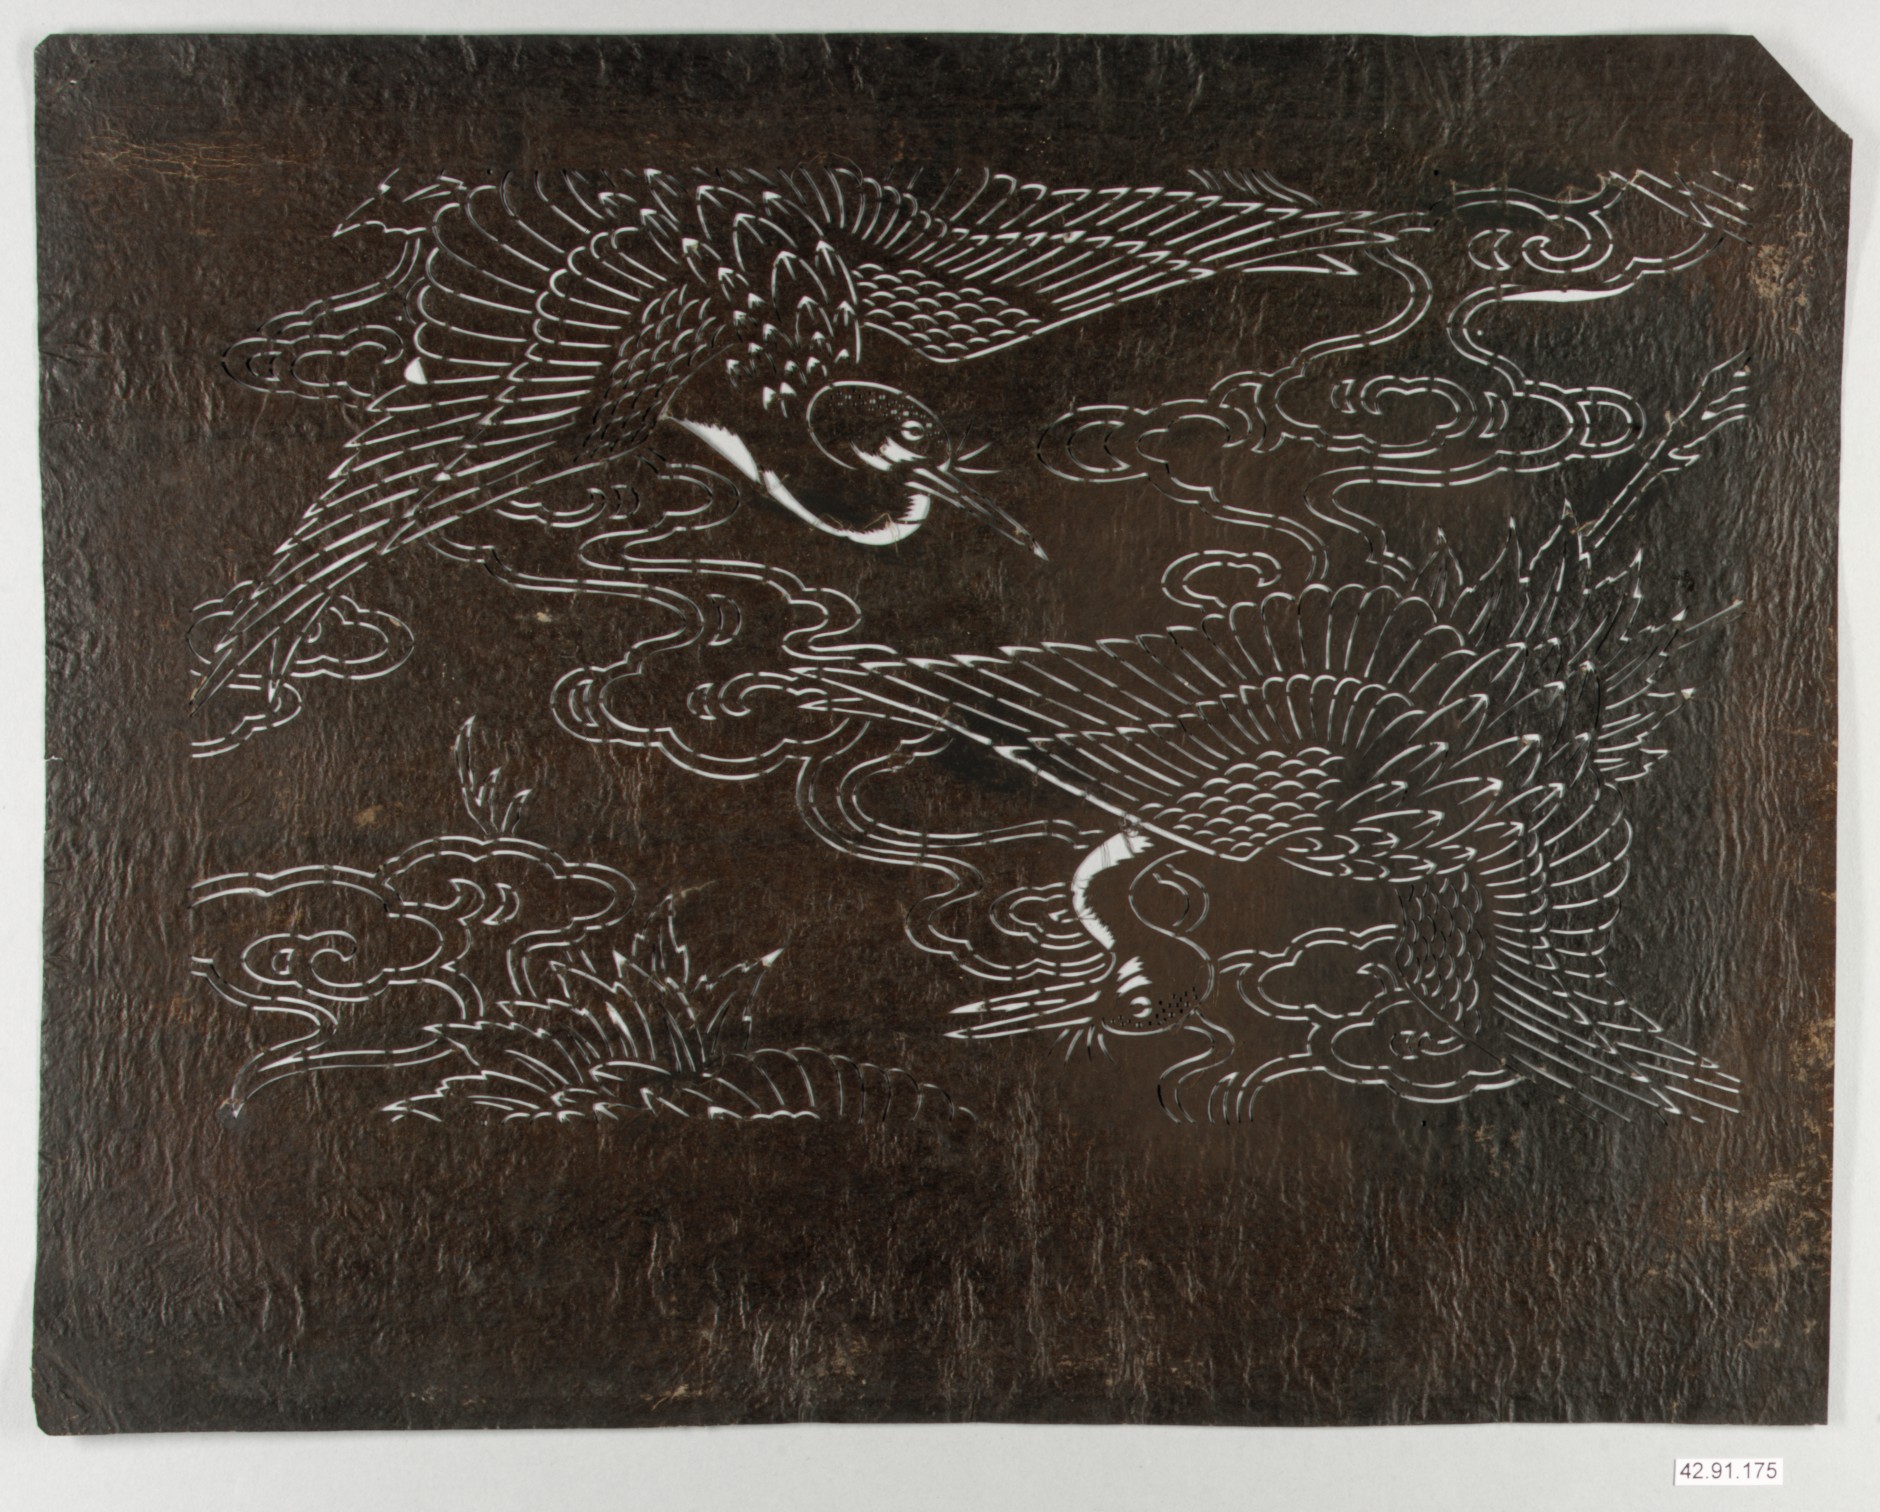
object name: stencil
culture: japanese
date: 1801-1900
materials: paper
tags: birds